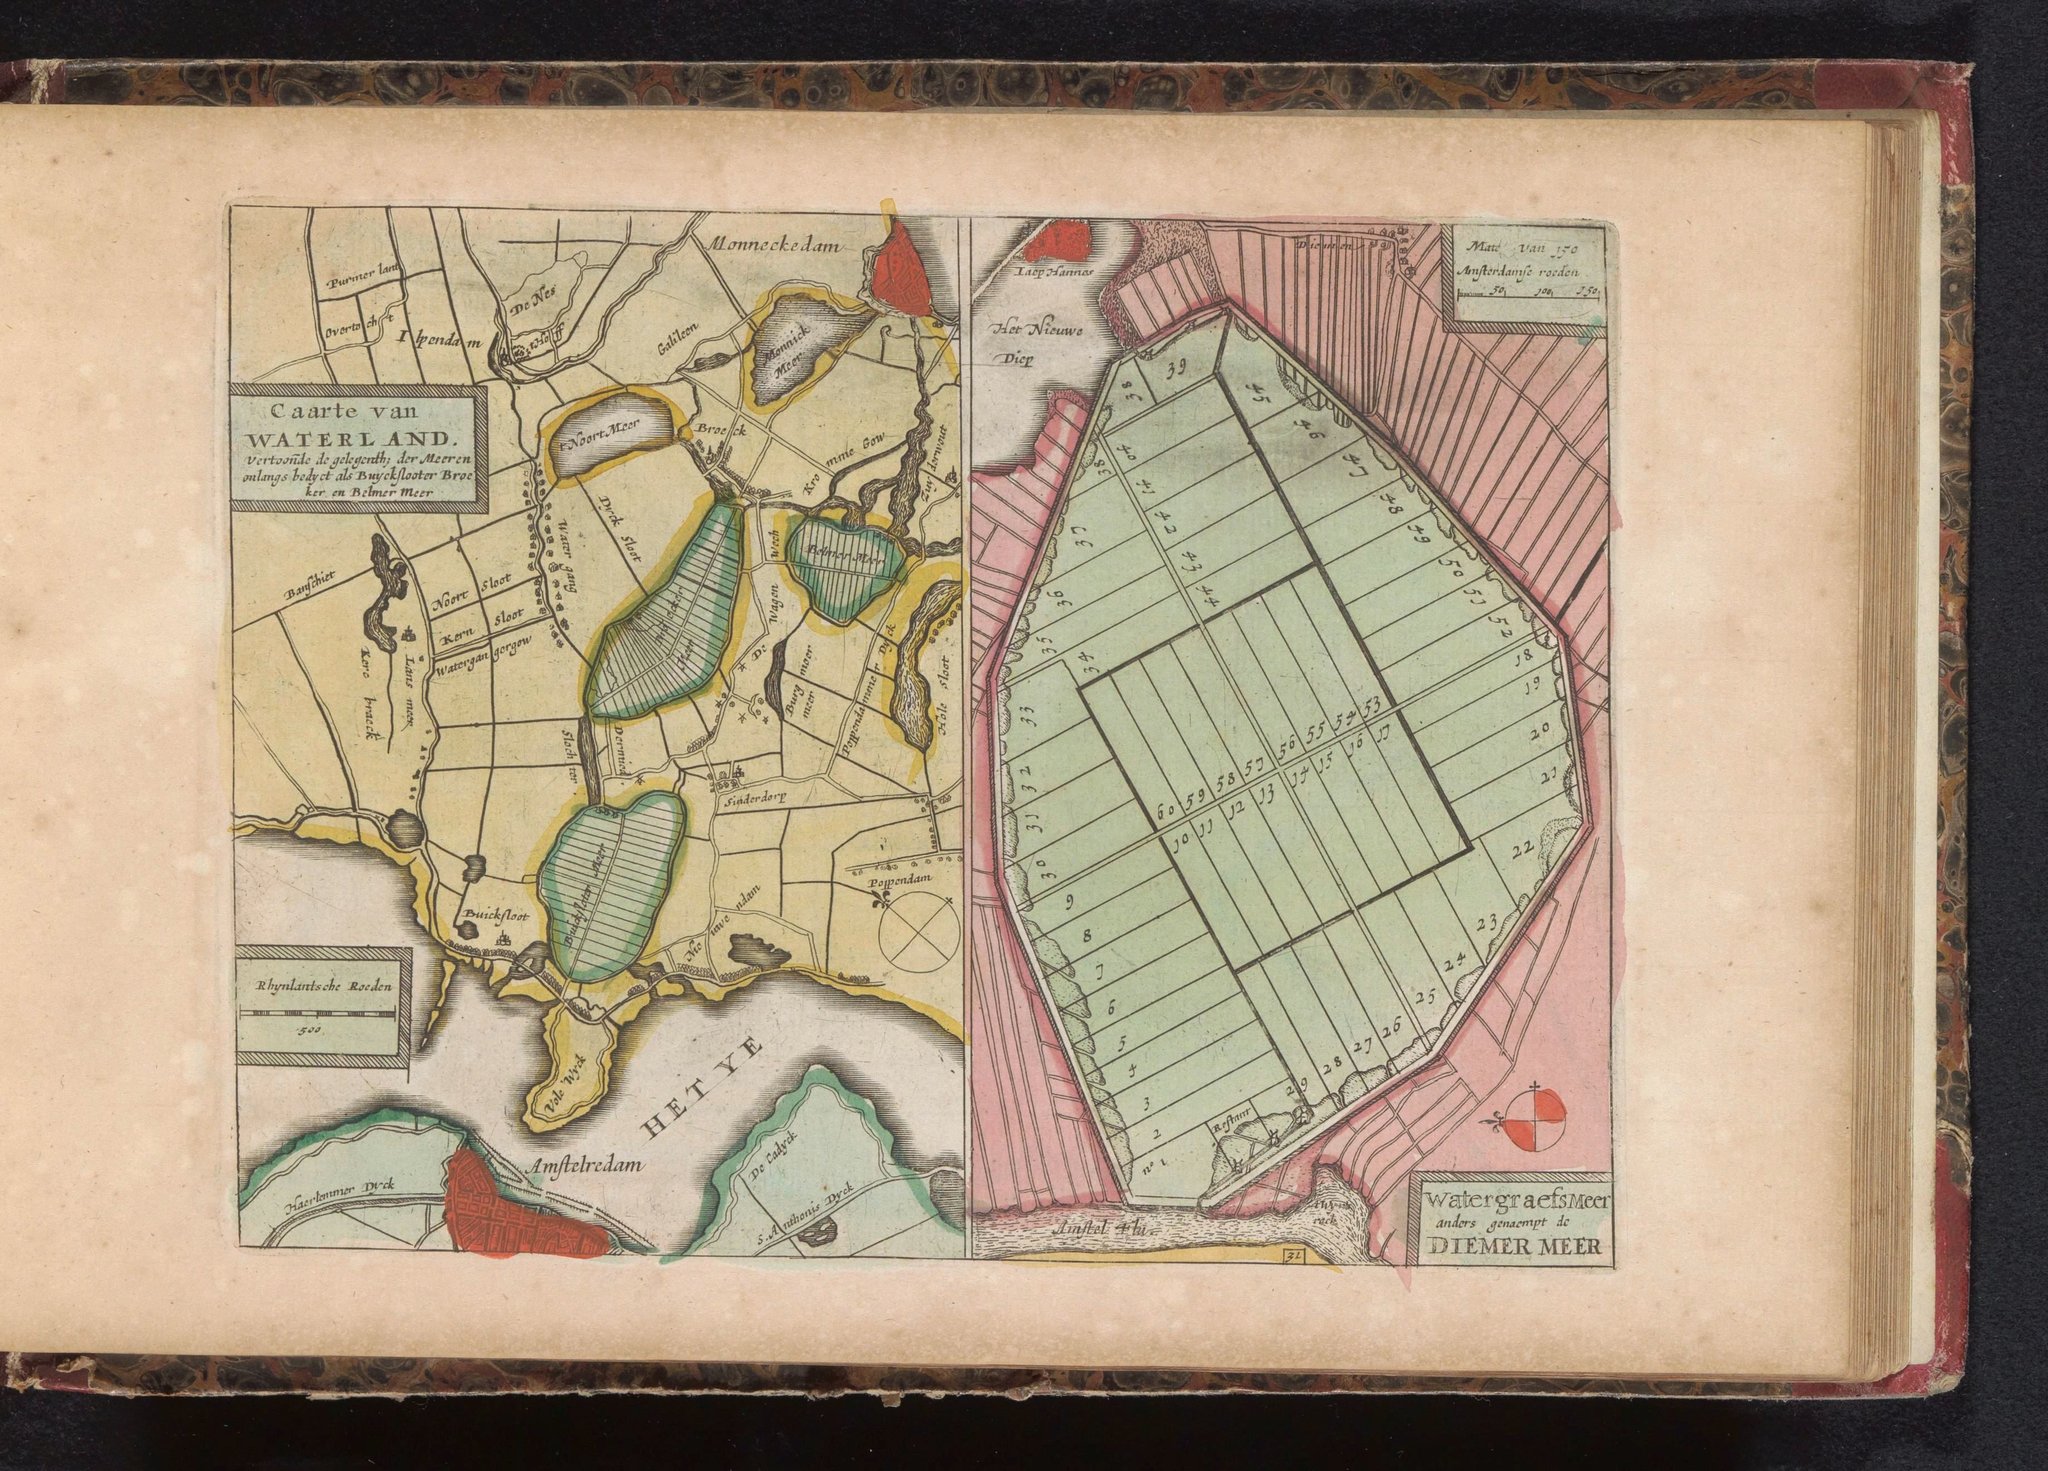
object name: map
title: Kaarten van polders in Waterland en Watergraafsmeer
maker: Anonymous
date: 1700-1702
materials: paper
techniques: engraving, etching, hand coloring, lacquer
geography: northern netherlands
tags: maps of separate countries or regions, polder, reclaimed land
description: Twee kaarten van de inpolderingen in Waterland en de Watergraafsmeer. Onderdeel van een atlas met 223 kaarten van landen en steden en oorlogstaferelen in Europa in de periode ca. 1690-1735.